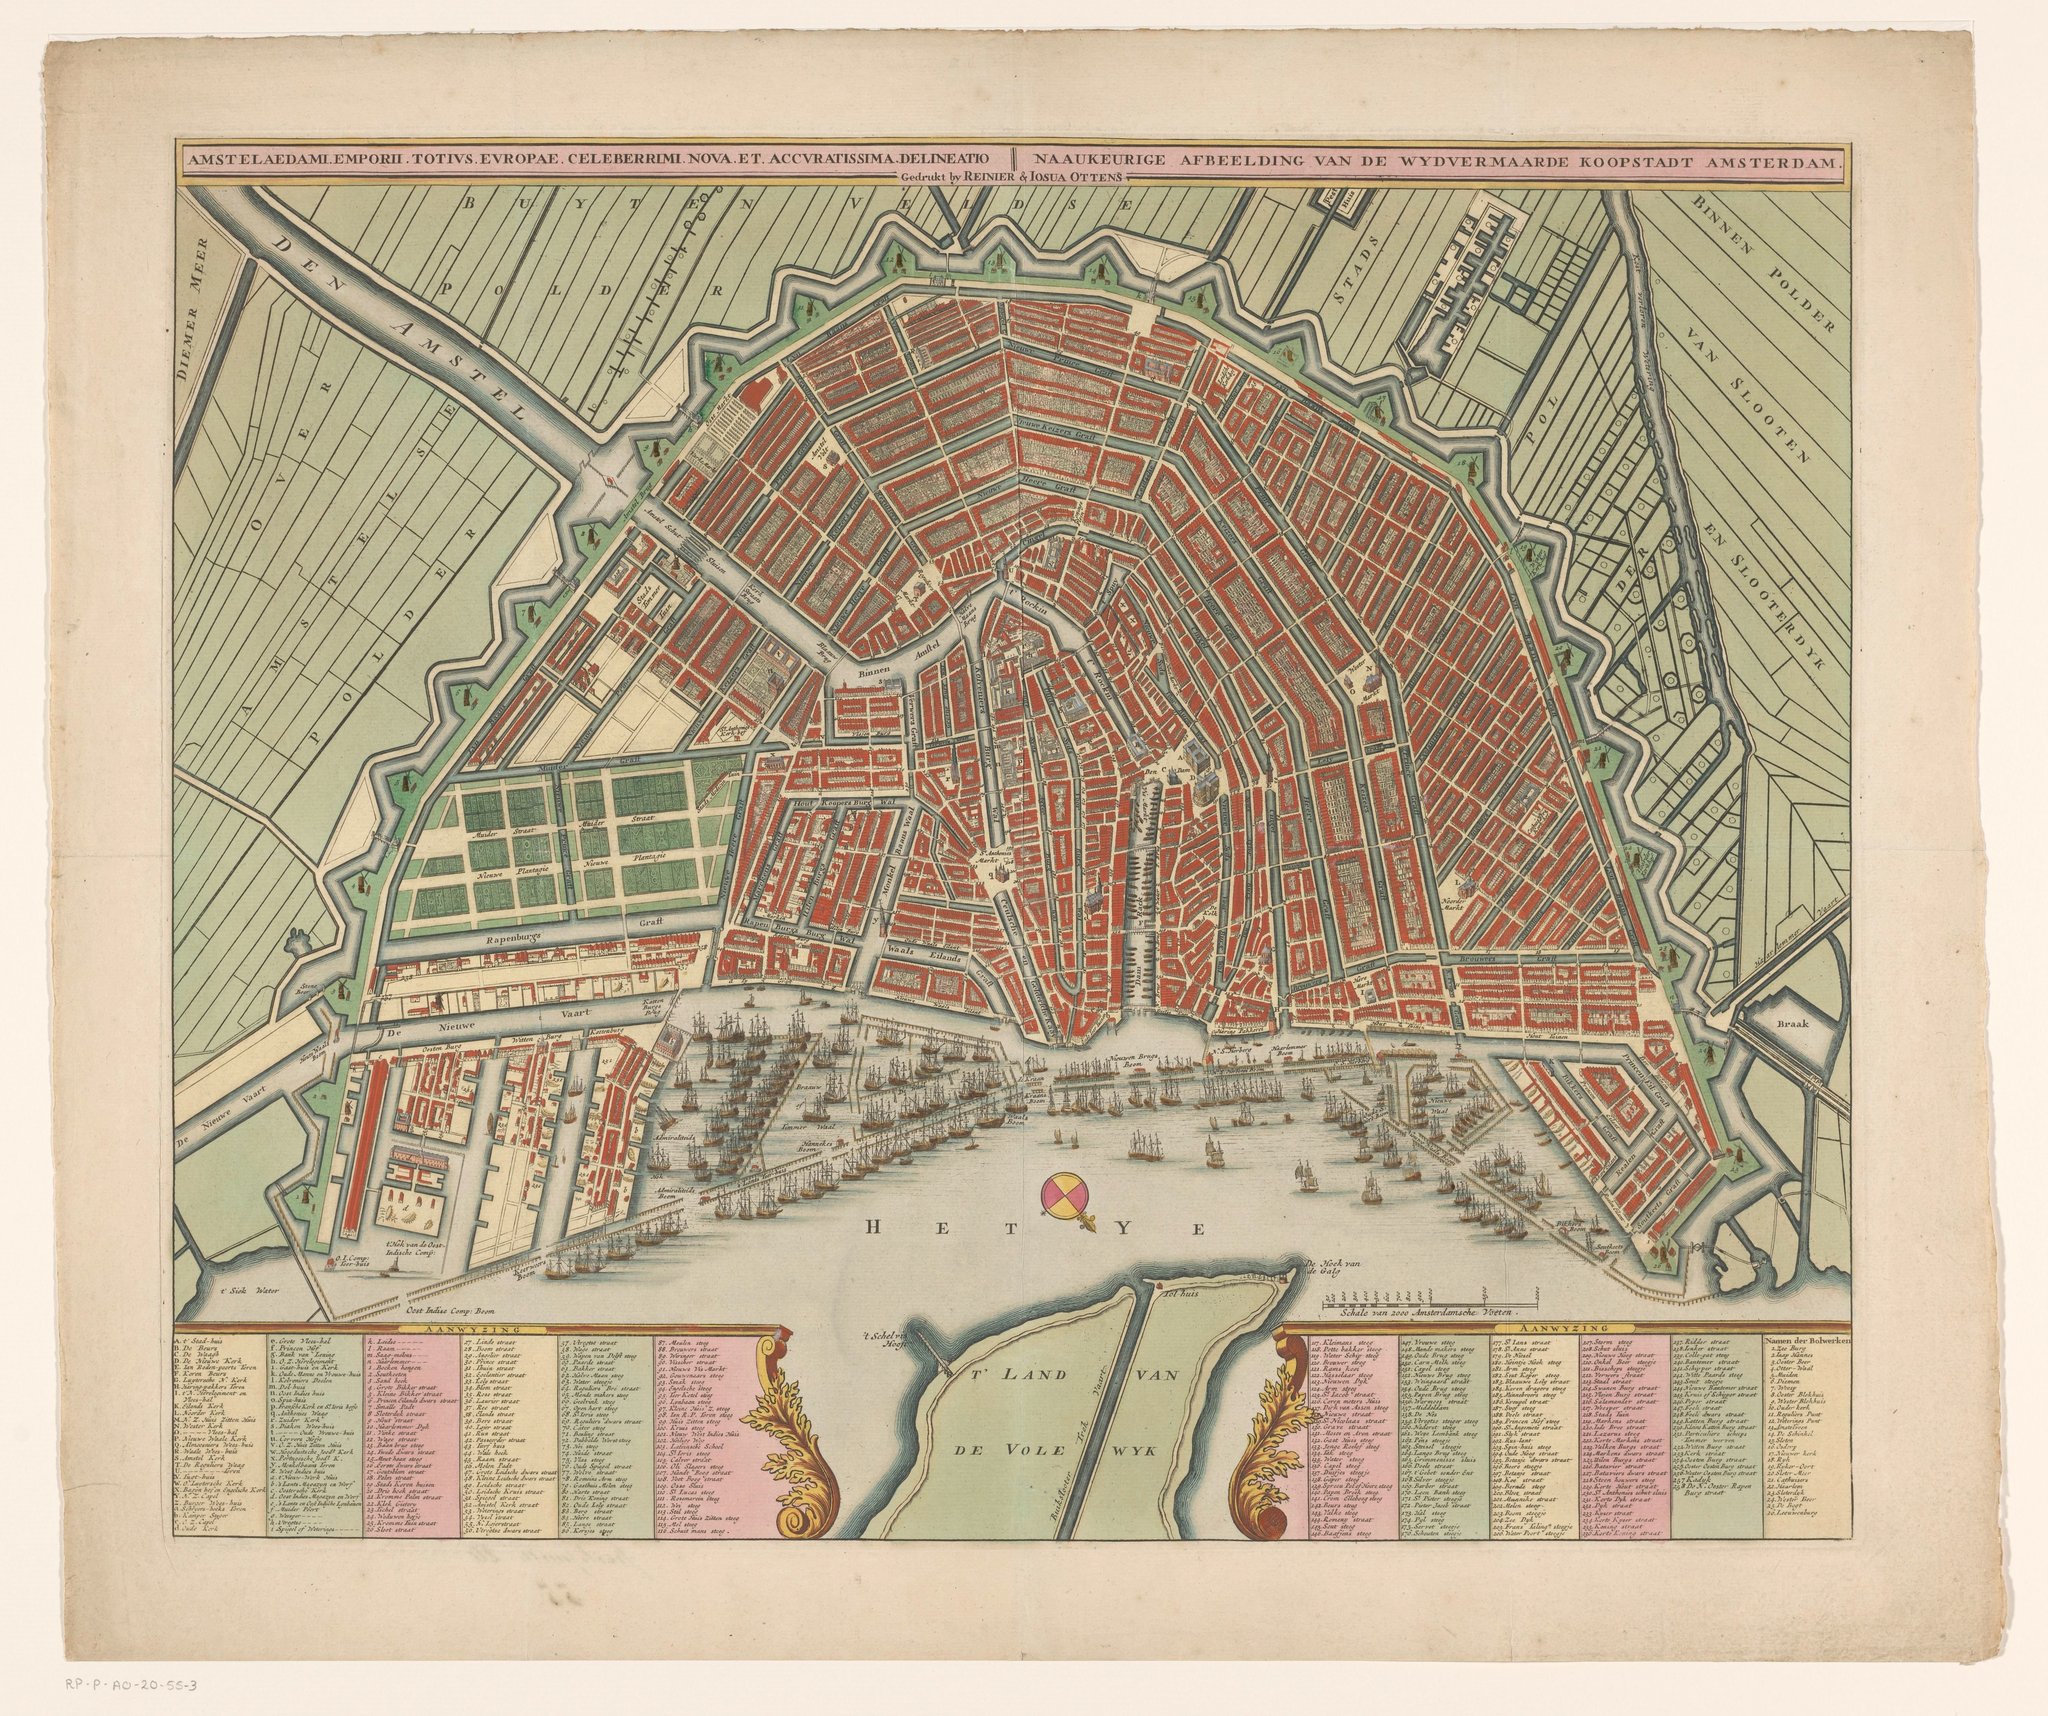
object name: area plan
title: Plattegrond van Amsterdam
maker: Anonymous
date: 1726-1750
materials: paper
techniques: engraving, etching, hand coloring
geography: amsterdam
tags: maps of cities, amsterdam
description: Plattegrond in vogelvluchtperspectief. Langs de bovenkant de titel. Linksonder de legenda A-Z, a-z, a-n en 1-116. Rechtsonder de legenda 117-258 en de legenda van de bolwerken 1-26. Daarboven een schaalstok: Scale van 2000 Amsterdamsche Voeten. Oriëntatie: zuidzuidwest boven.